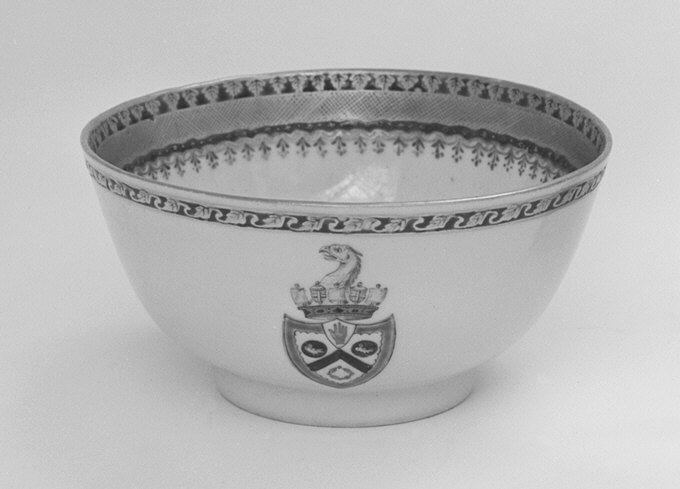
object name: teacup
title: Tea cup (part of a service)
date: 1785-1800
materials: hard paste porcelain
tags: coat of arms